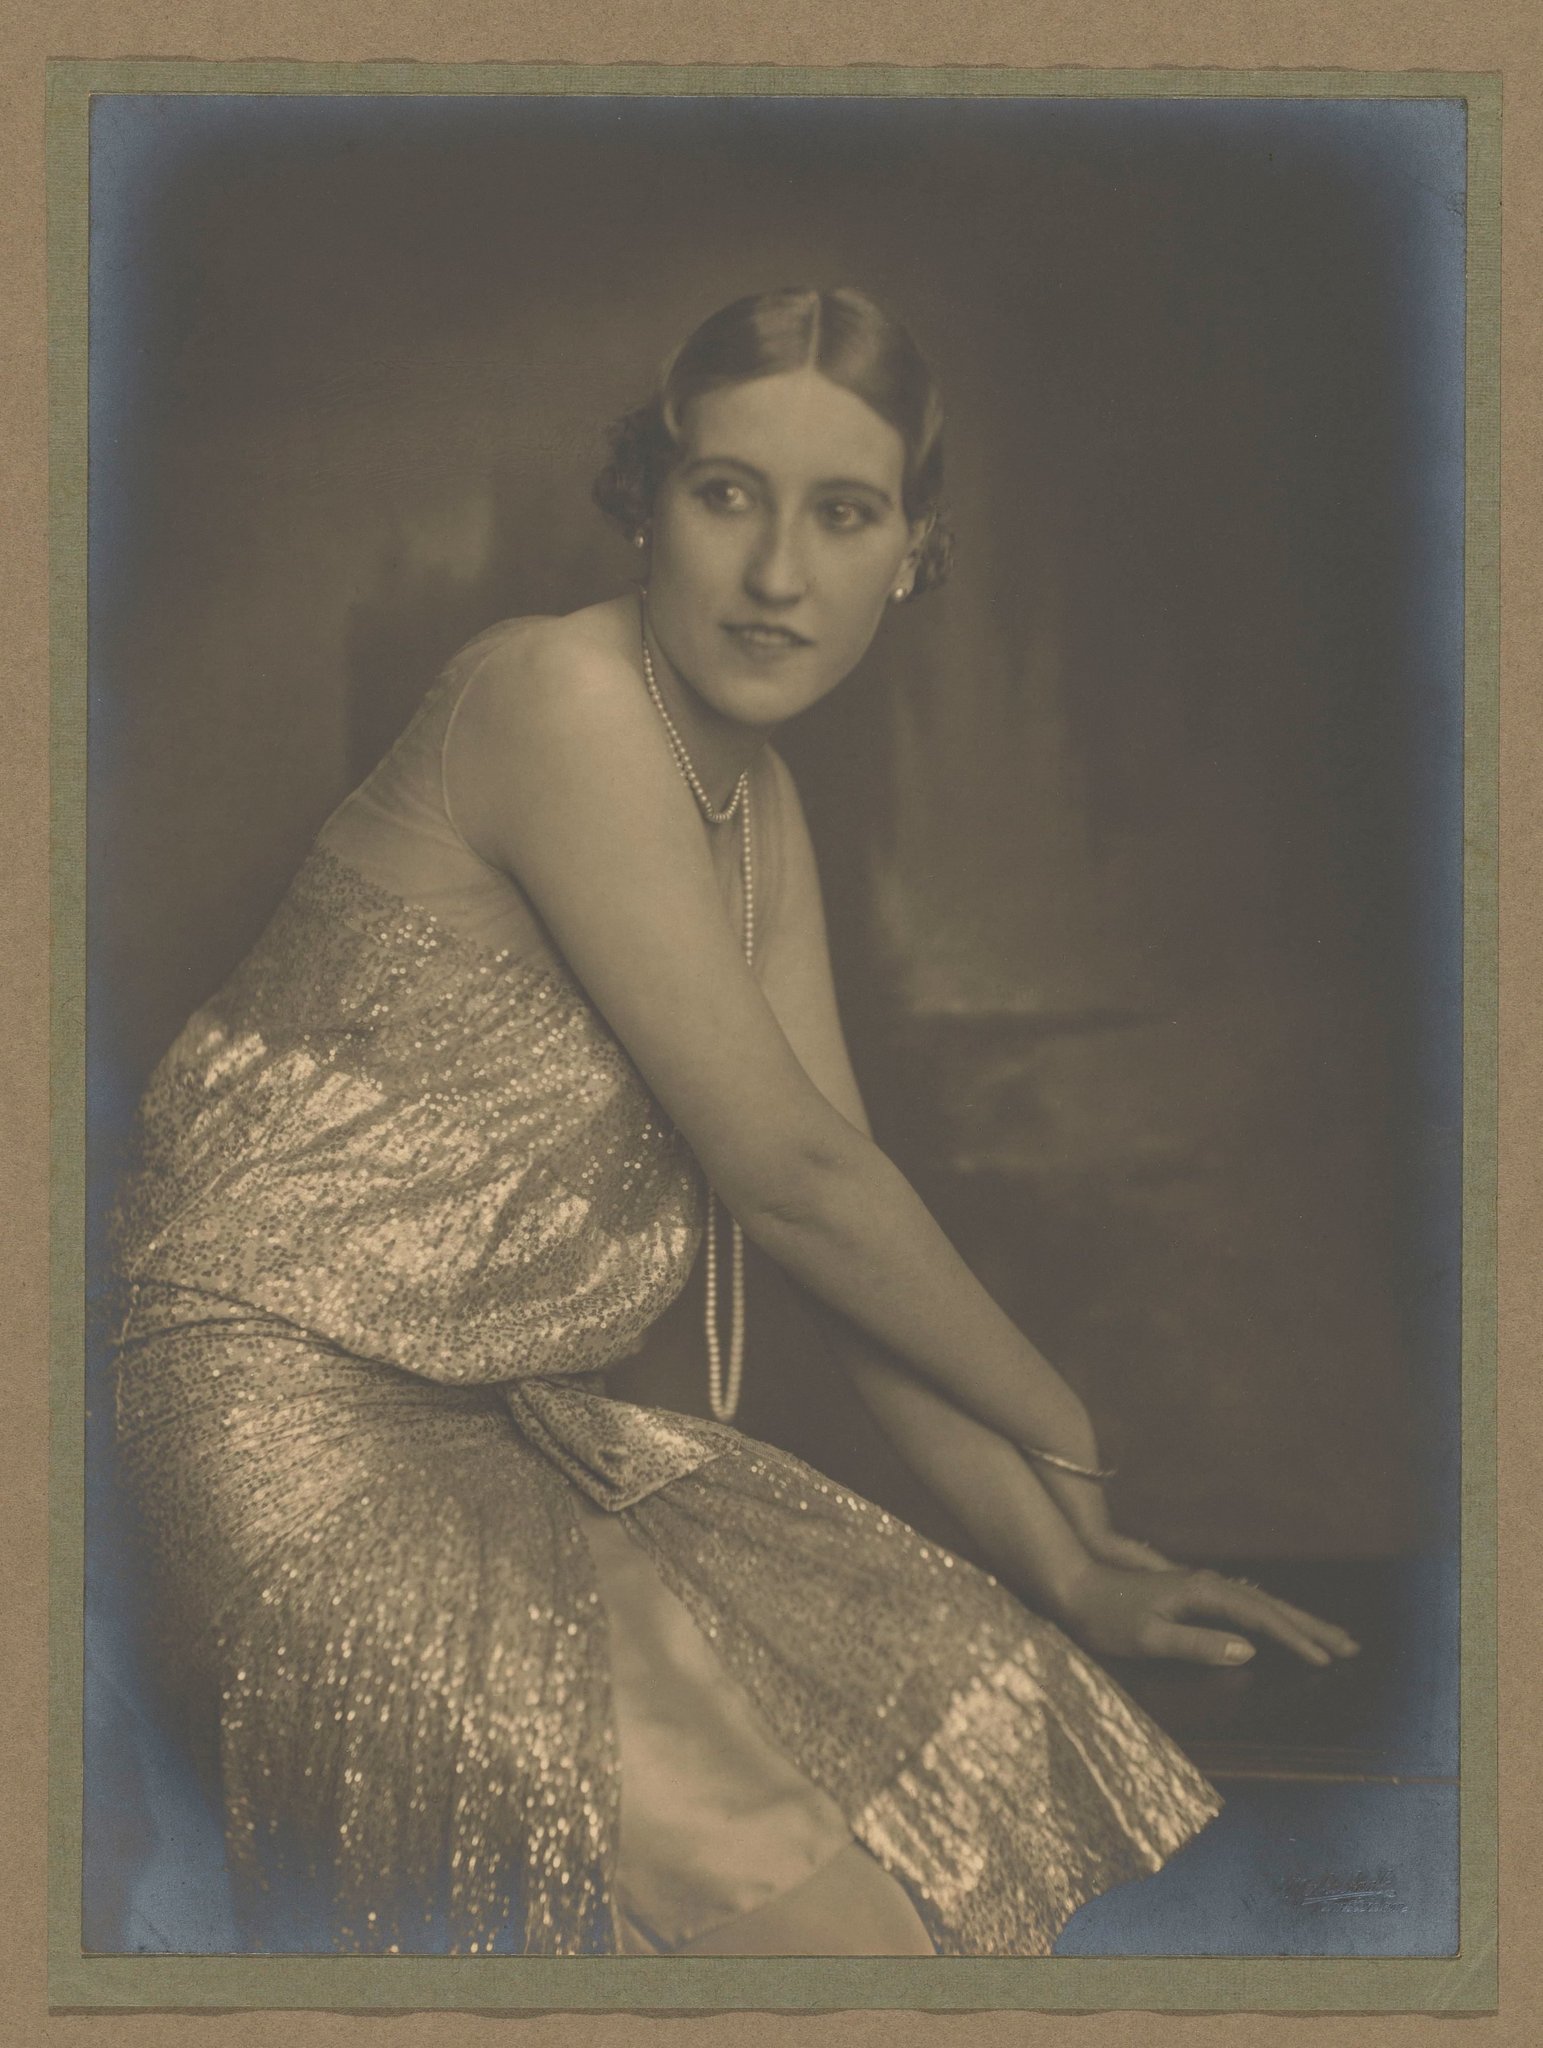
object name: photograph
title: Portret Lettie van Lier-van Wijk, mannequin van Hirsch, in japon zittend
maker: jacob merkelbach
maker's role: fotograaf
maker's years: 1877-1942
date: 1920-1930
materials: cardboard, photographic support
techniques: gelatin silver print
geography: amsterdam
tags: historical persons (portraits and scenes from the life) - bb - woman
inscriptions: annotation: ‘Lettie van Lier-van Wijk, mannequin van Hirsch’